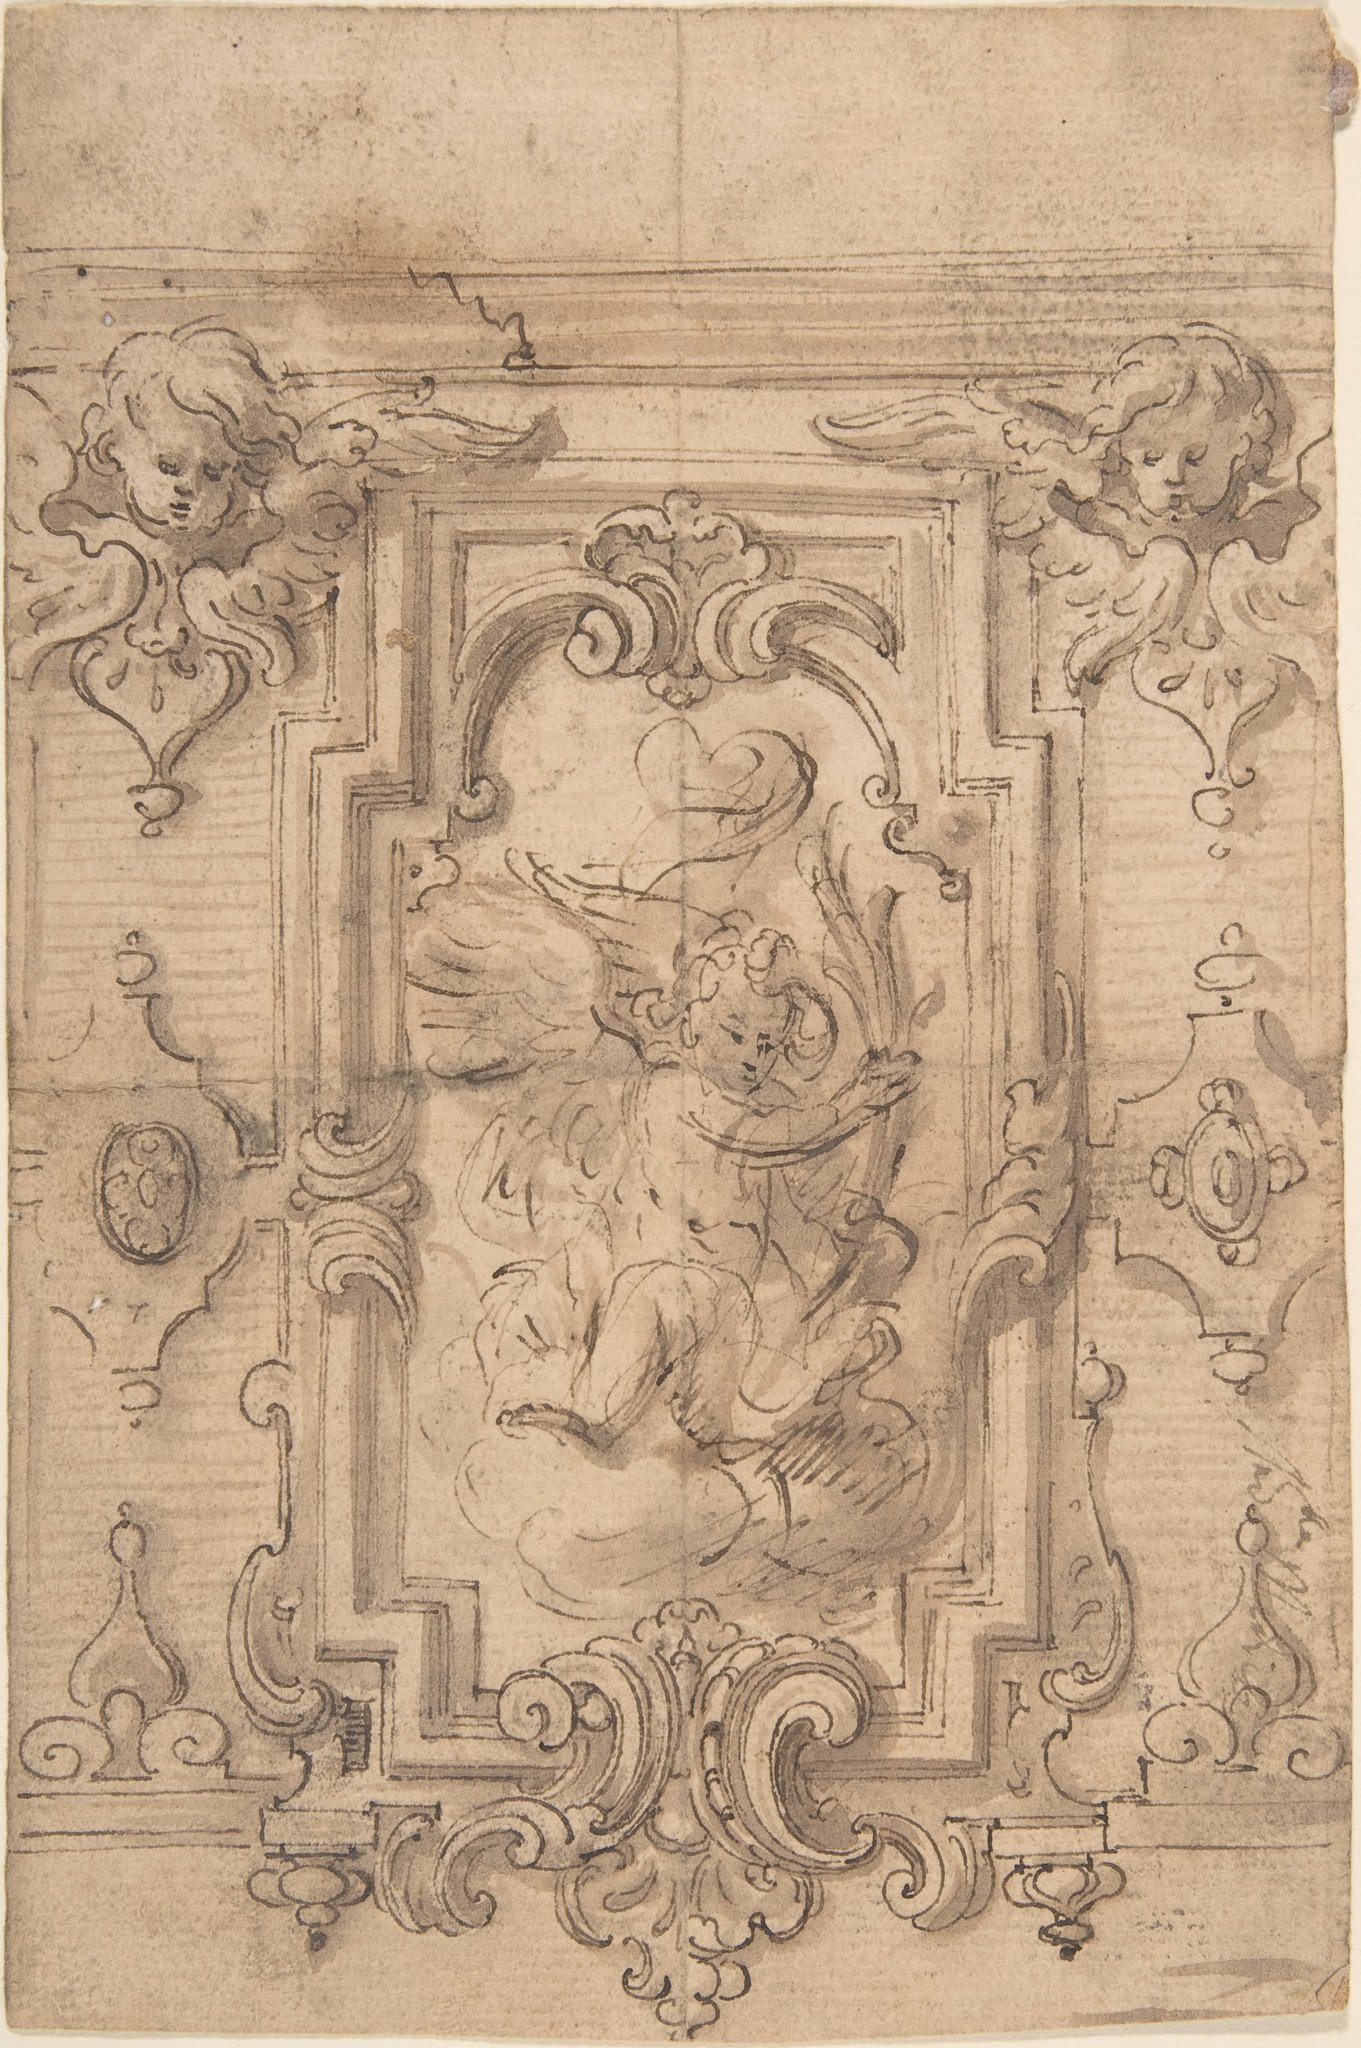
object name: drawing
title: Wall Design with Flying Putto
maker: anonymous, italian, 17th or 18th century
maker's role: artist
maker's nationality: italian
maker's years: 1600-1799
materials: ink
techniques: brush, pen, wash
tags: ornament,putti